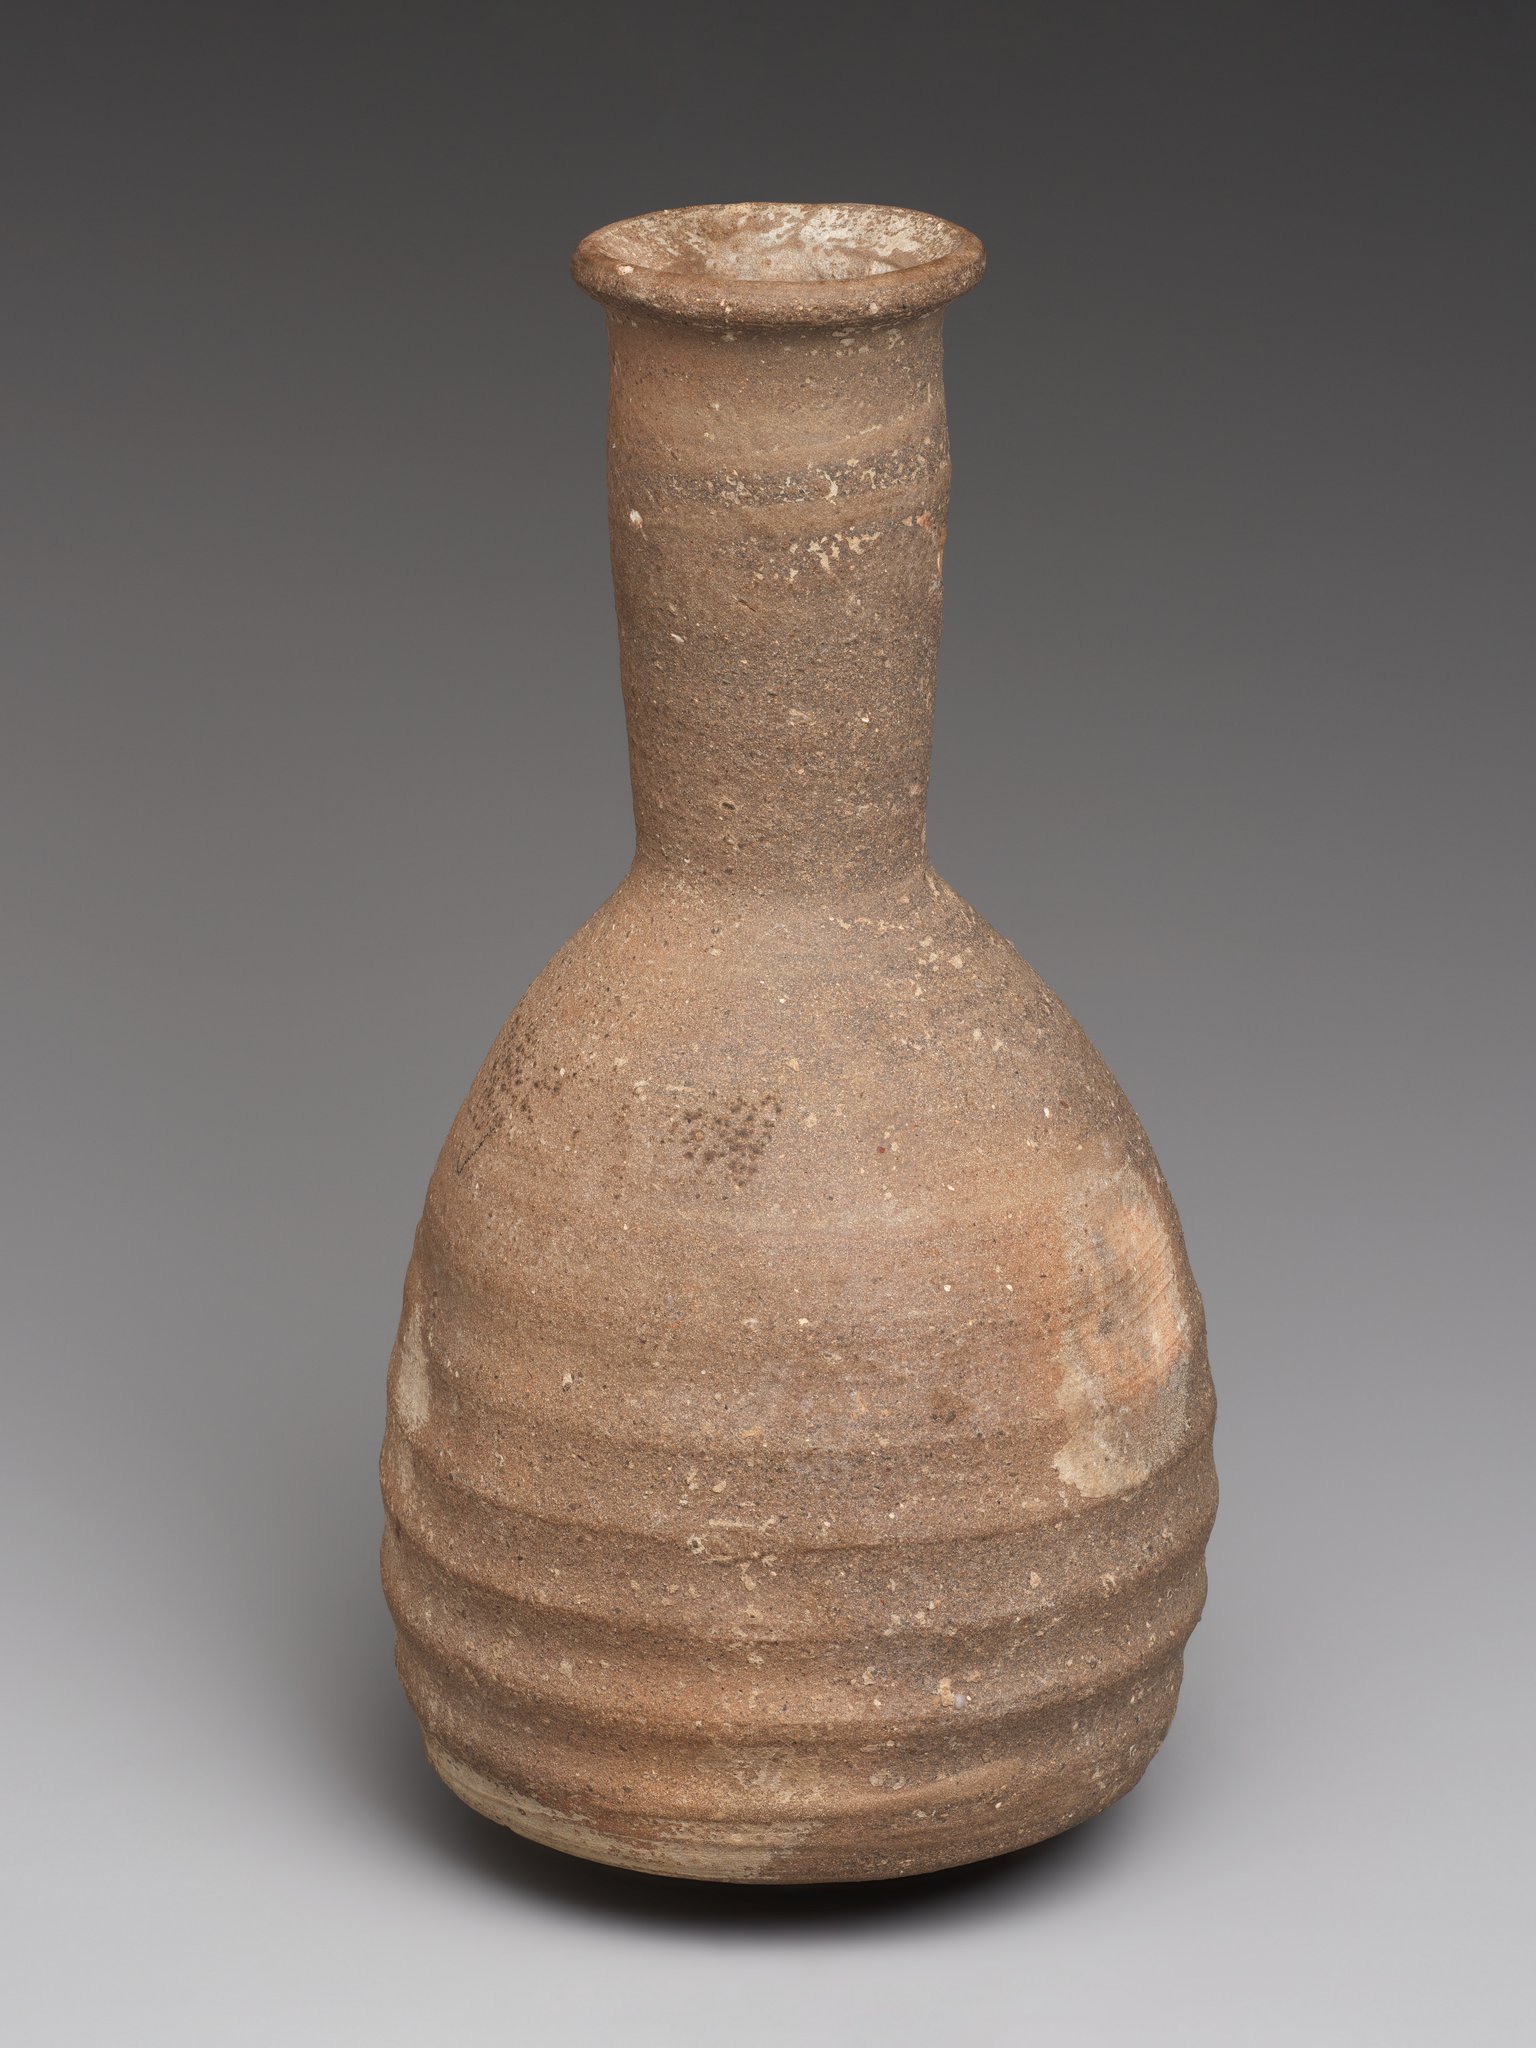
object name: vessel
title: Unguentarium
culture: nabataean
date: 1-100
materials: ceramic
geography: levant